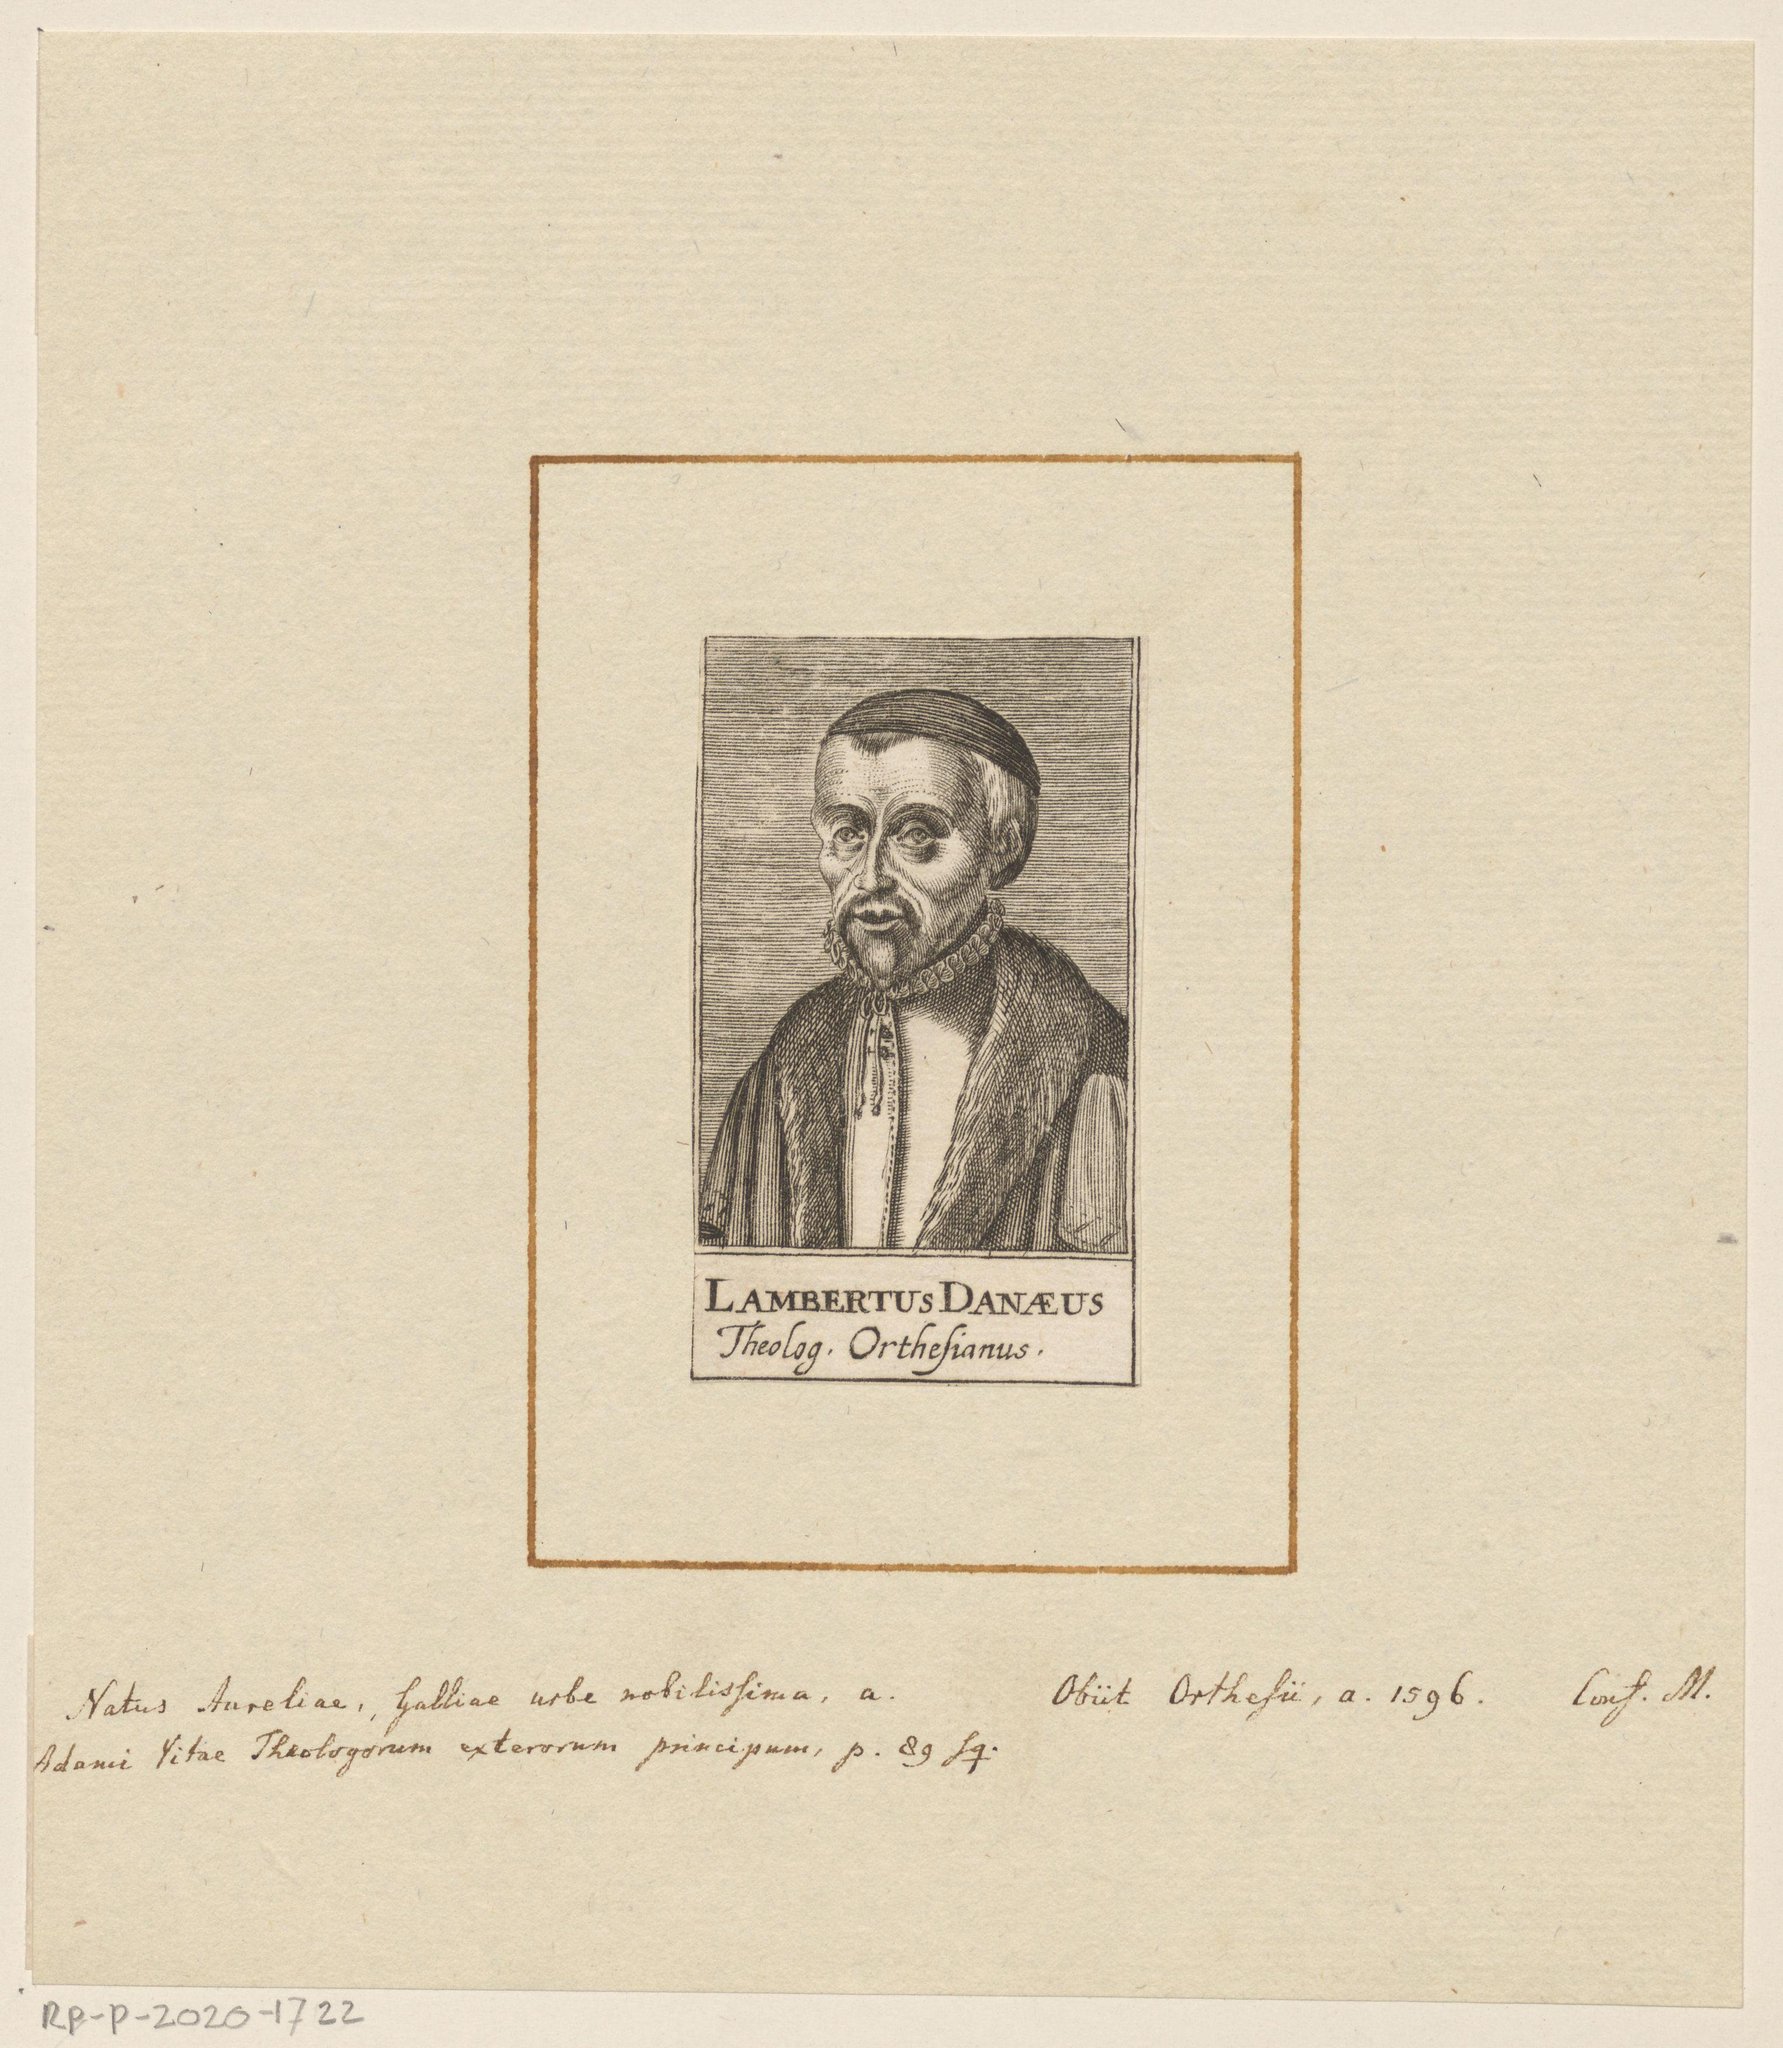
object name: print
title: Portret van Lambert Daneau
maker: Anonymous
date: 1688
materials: paper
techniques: engraving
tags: theologian, historical persons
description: Prent maakt deel uit van een grotere prent die later is verknipt. Prent is ook gebruikt in: Freher, Paul. Theatrum virorum eruditione clarorum. Neurenberg: Johann Hoffmann, 1688.